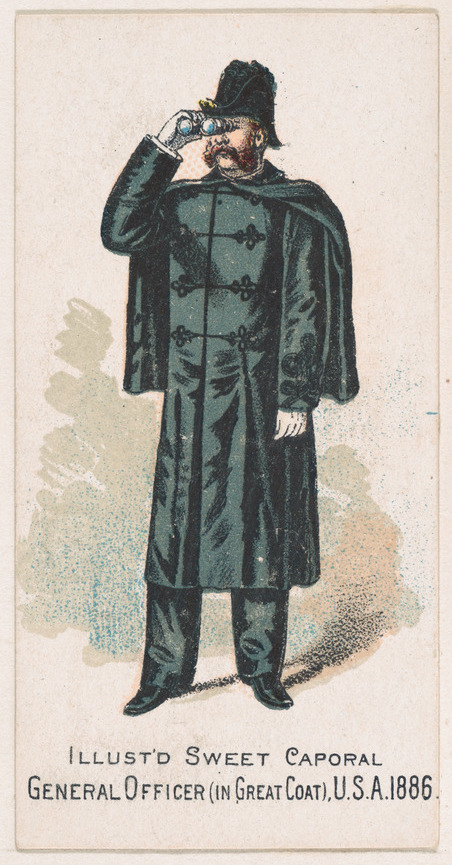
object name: print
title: General Officer in Great Coat, United States Army, 1886, from the Military Series (N224) issued by Kinney Tobacco Company to promote Sweet Caporal Cigarettes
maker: kinney brothers tobacco company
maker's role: publisher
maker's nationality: american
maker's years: 1869-2011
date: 1888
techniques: color lithograph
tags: men,generals